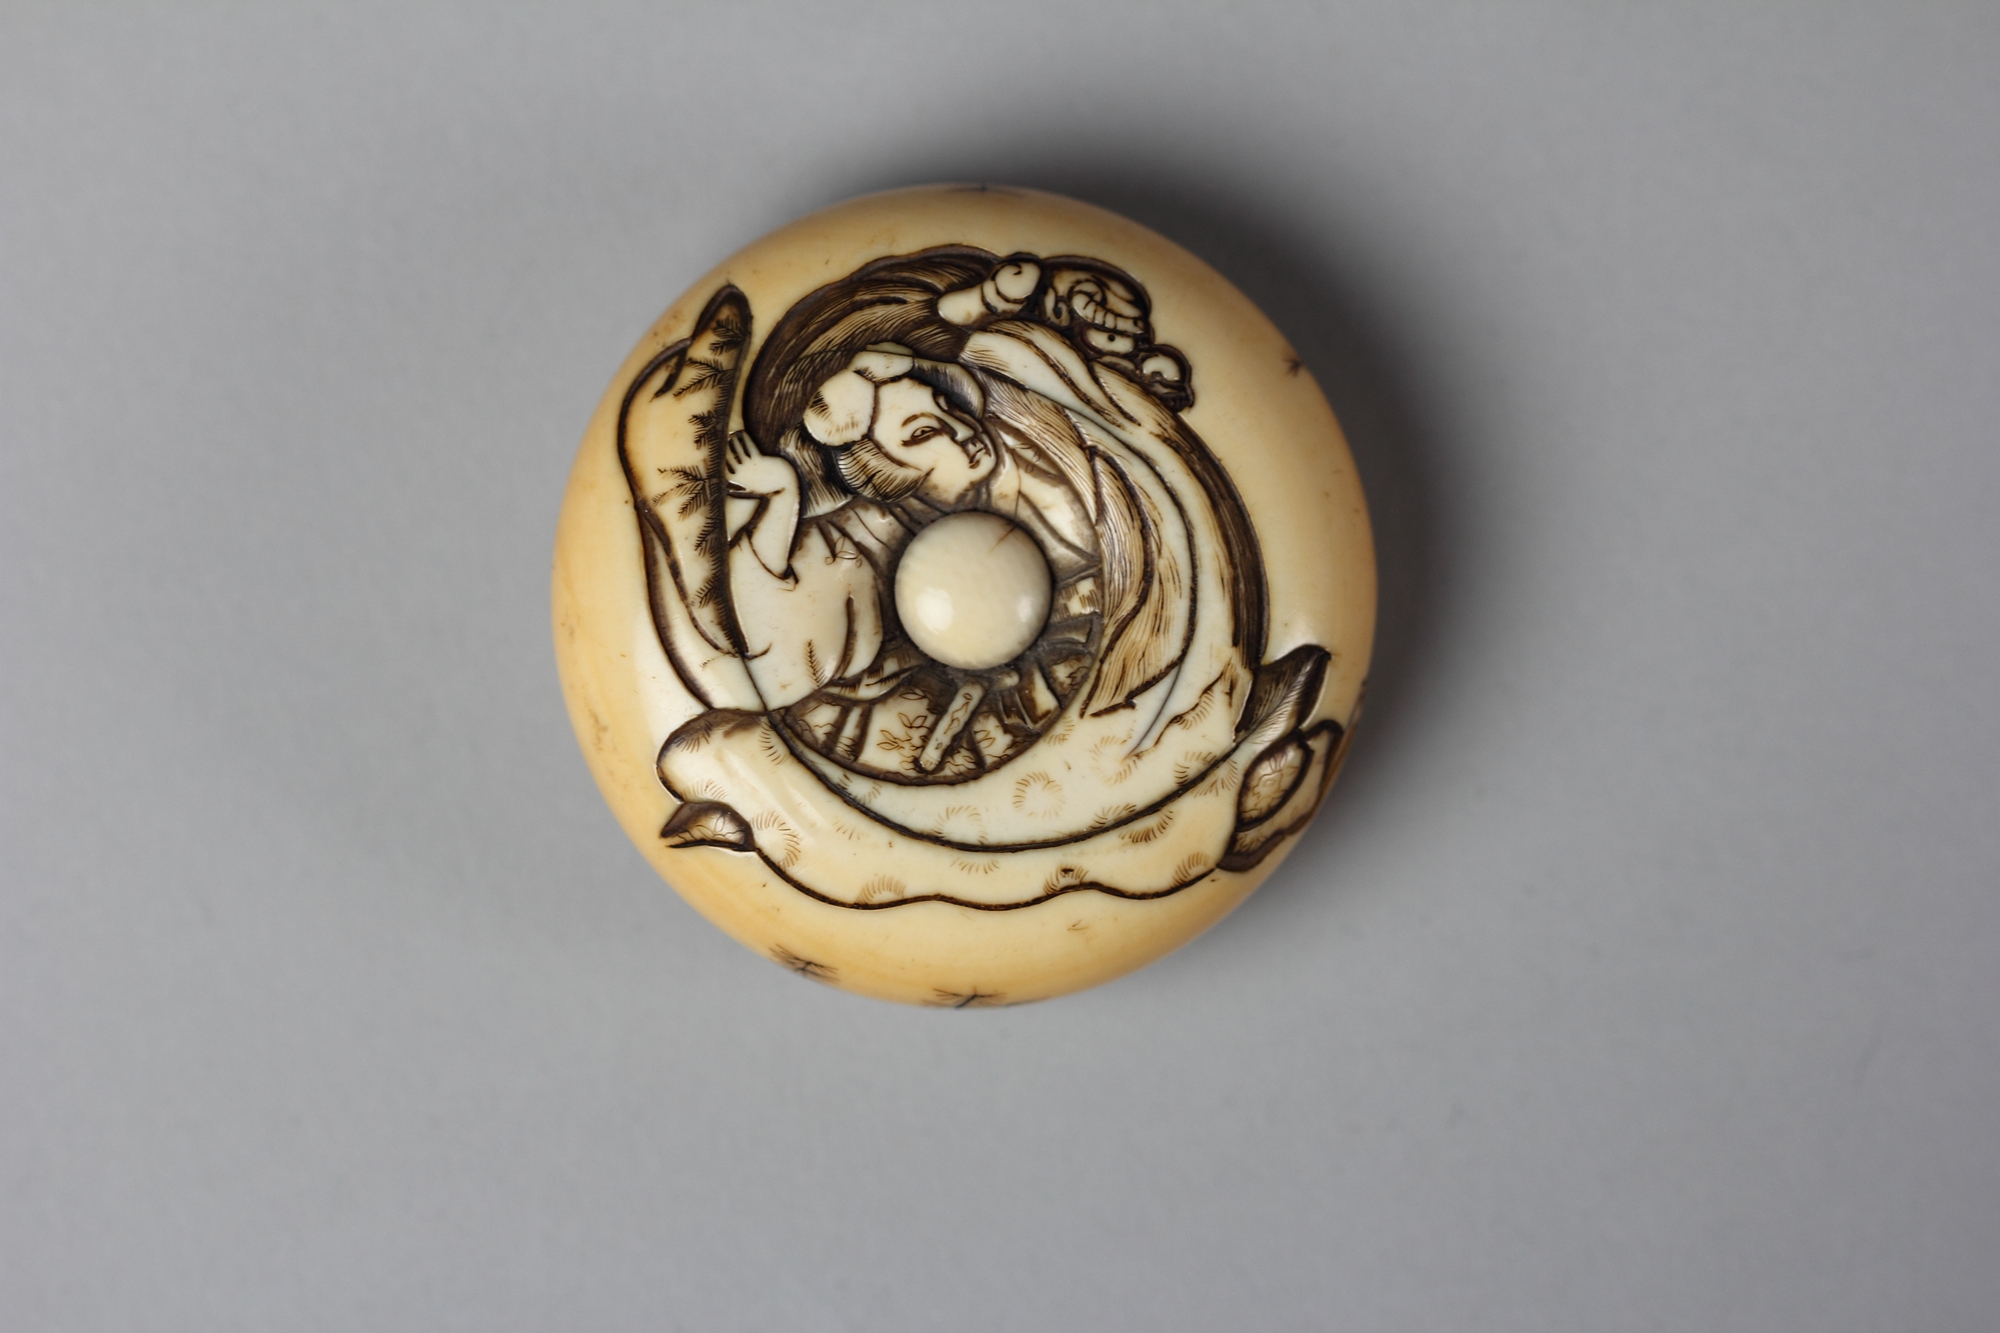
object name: netsuke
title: Netsuke of Woman with a Demon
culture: japanese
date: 1701-1800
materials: ivory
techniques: carving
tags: women,demons